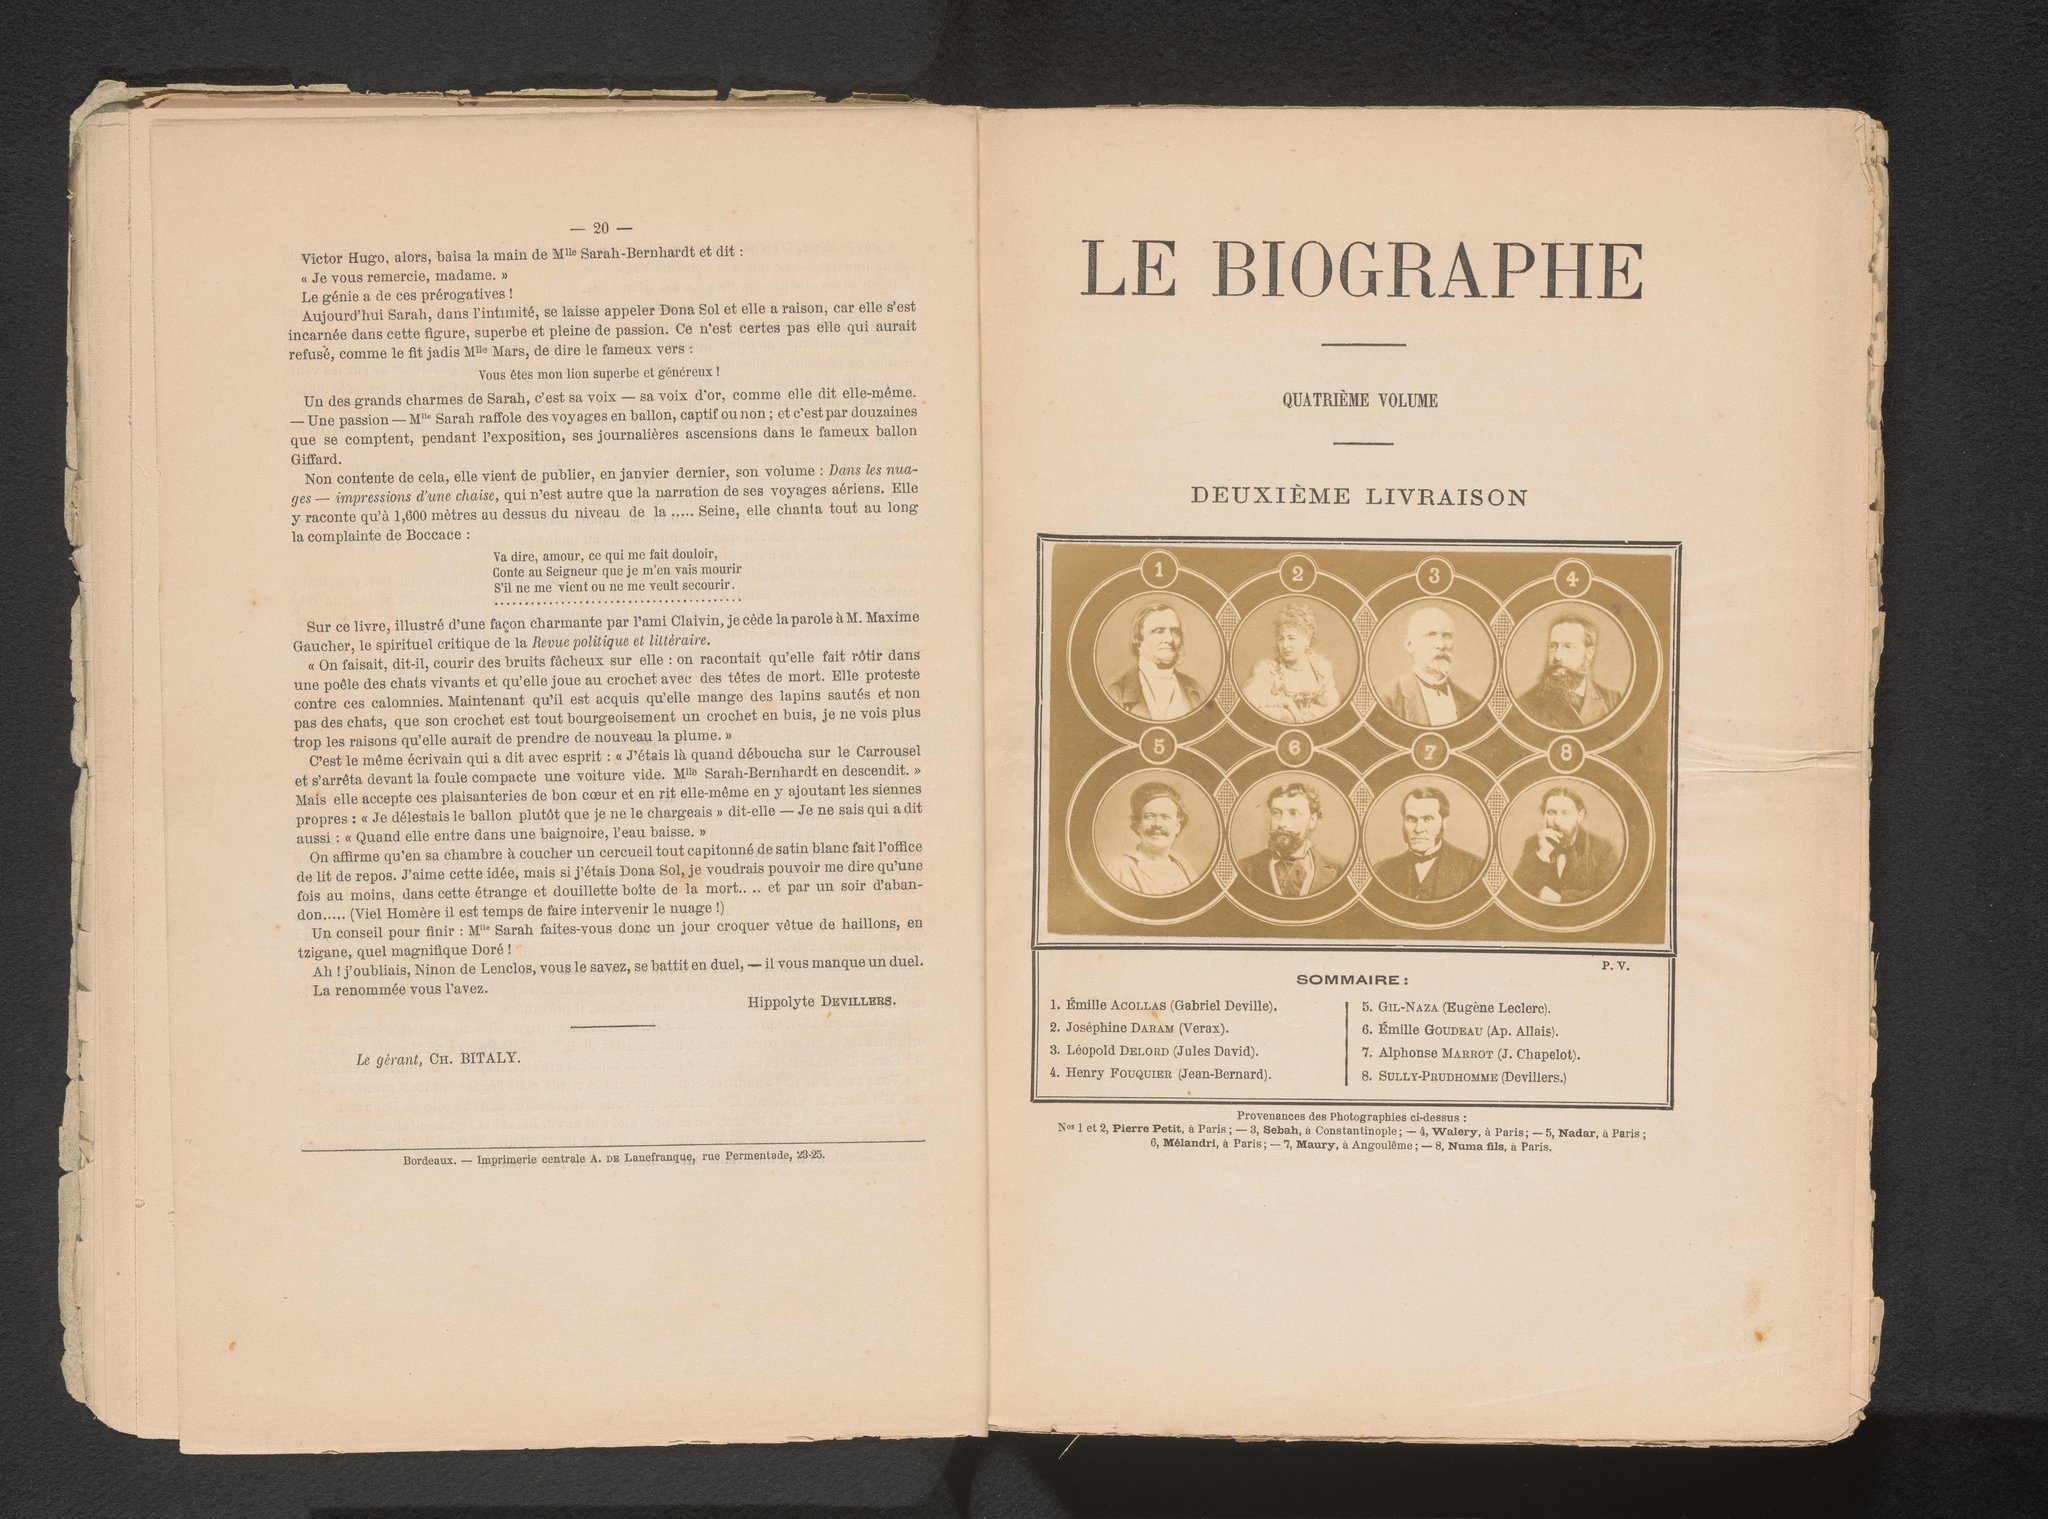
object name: page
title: Samengesteld groepsportret van acht beroemdheden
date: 1875-1880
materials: photographic support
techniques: albumen print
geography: paris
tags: paris, historical persons not known by name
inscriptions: inscription: ‘Sommaire: (...) (Devillers)’, number: ‘1 (...) 8’